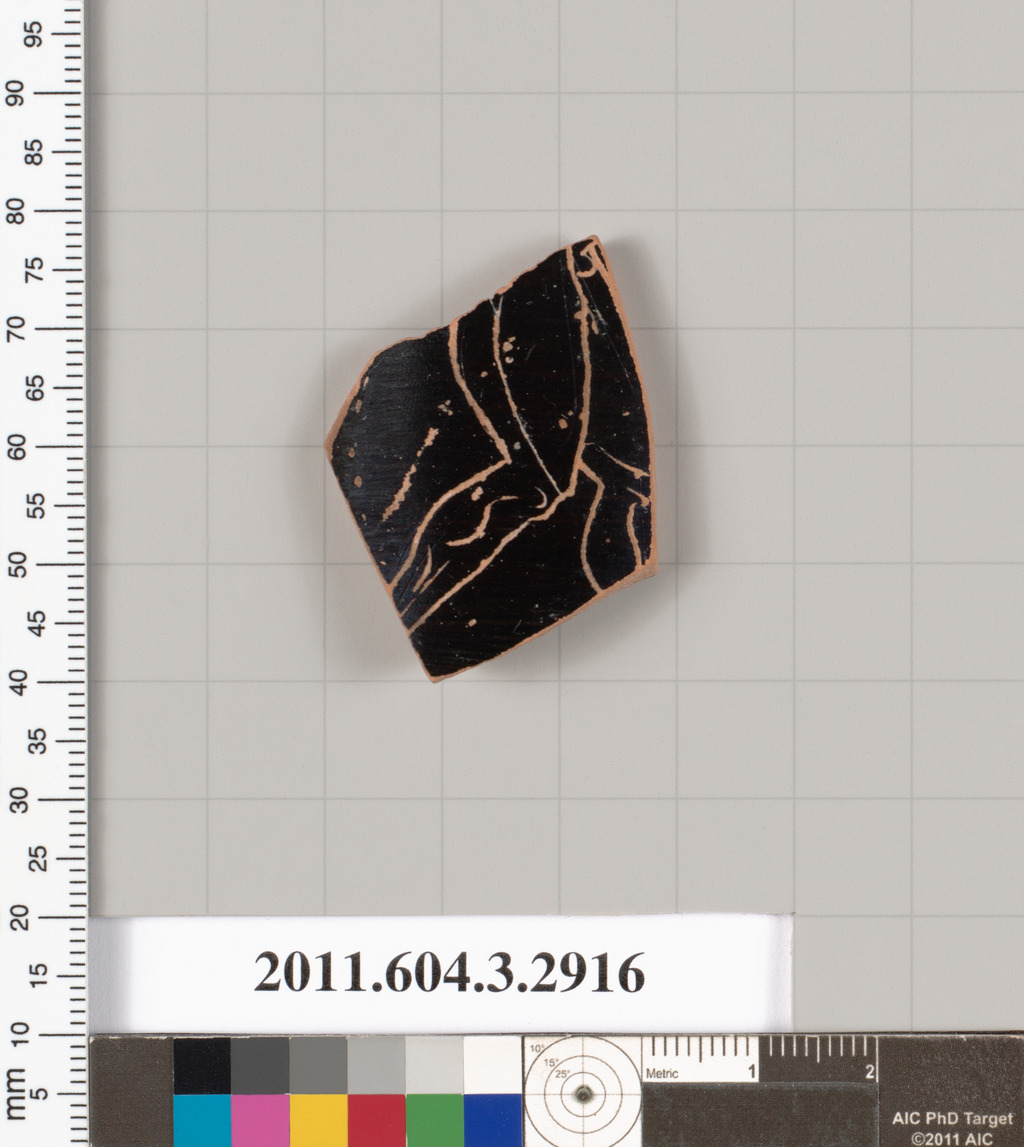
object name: lekythos fragment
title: Terracotta fragment of a lekythos (oil flask)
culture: greek, attic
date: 525-501 BCE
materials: terracotta